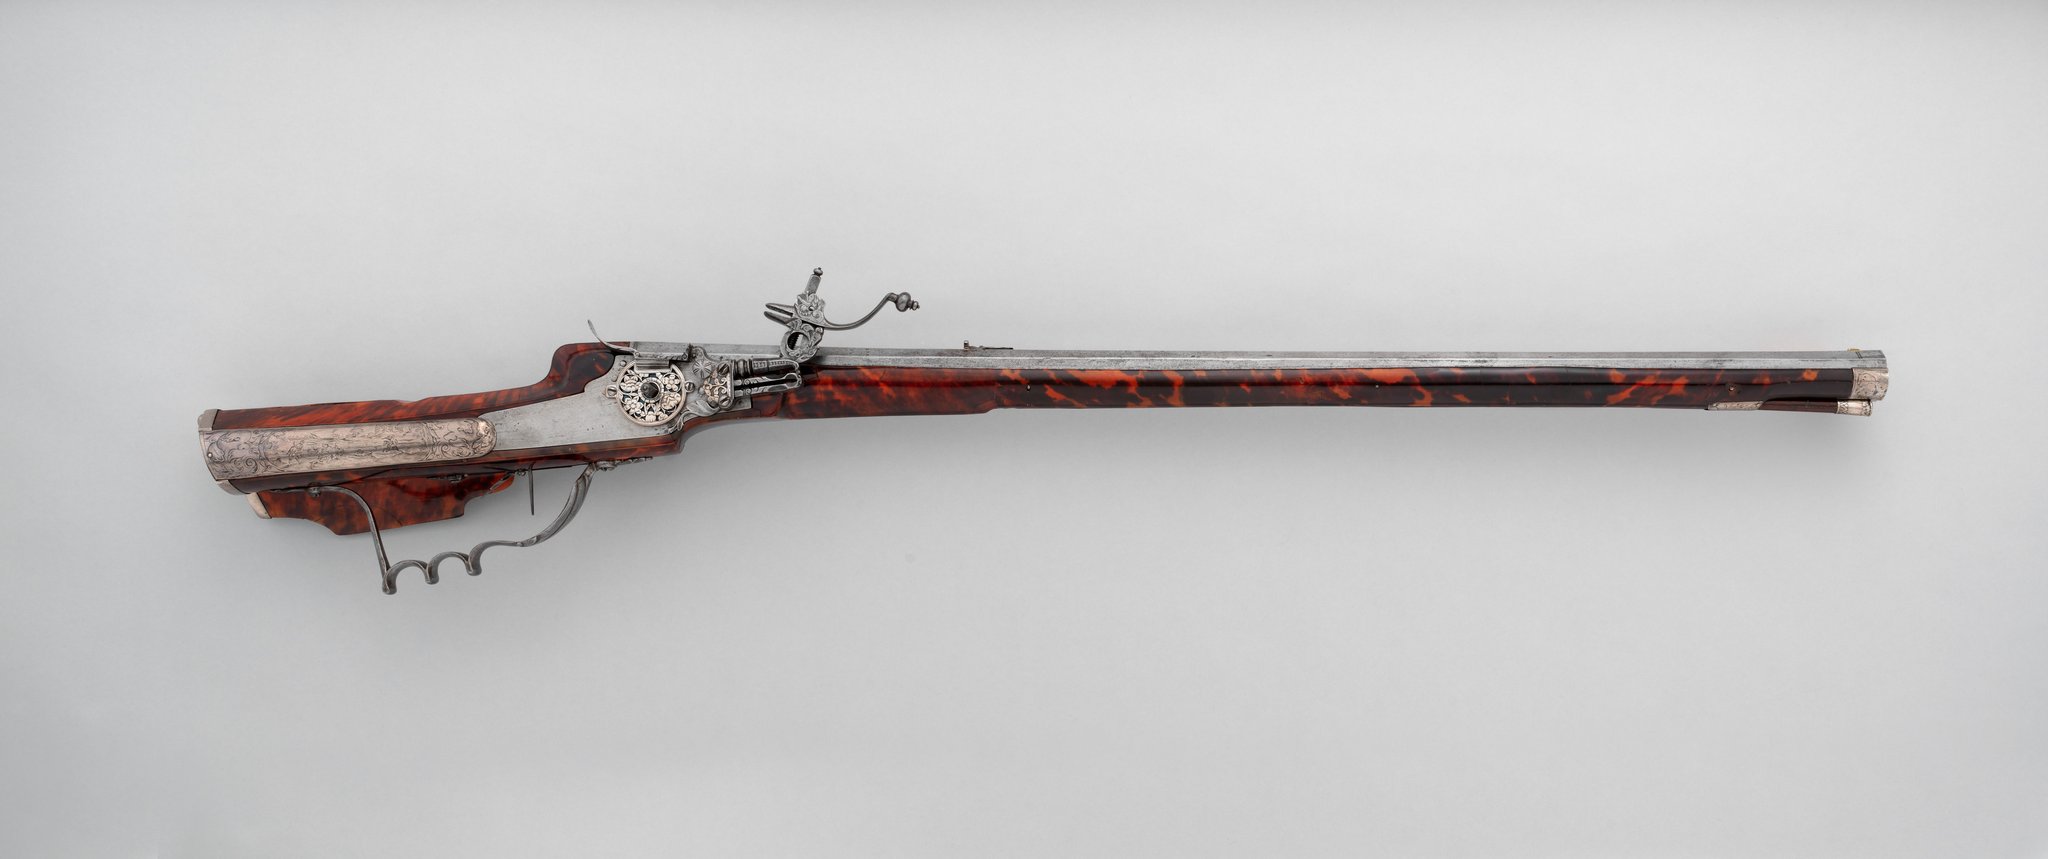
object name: wheellock rifle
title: Wheellock Sporting Rifle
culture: german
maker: martin kammerer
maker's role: gunsmith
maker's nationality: german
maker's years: 1654-1667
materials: iron, silver, steel, shell, wood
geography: germany